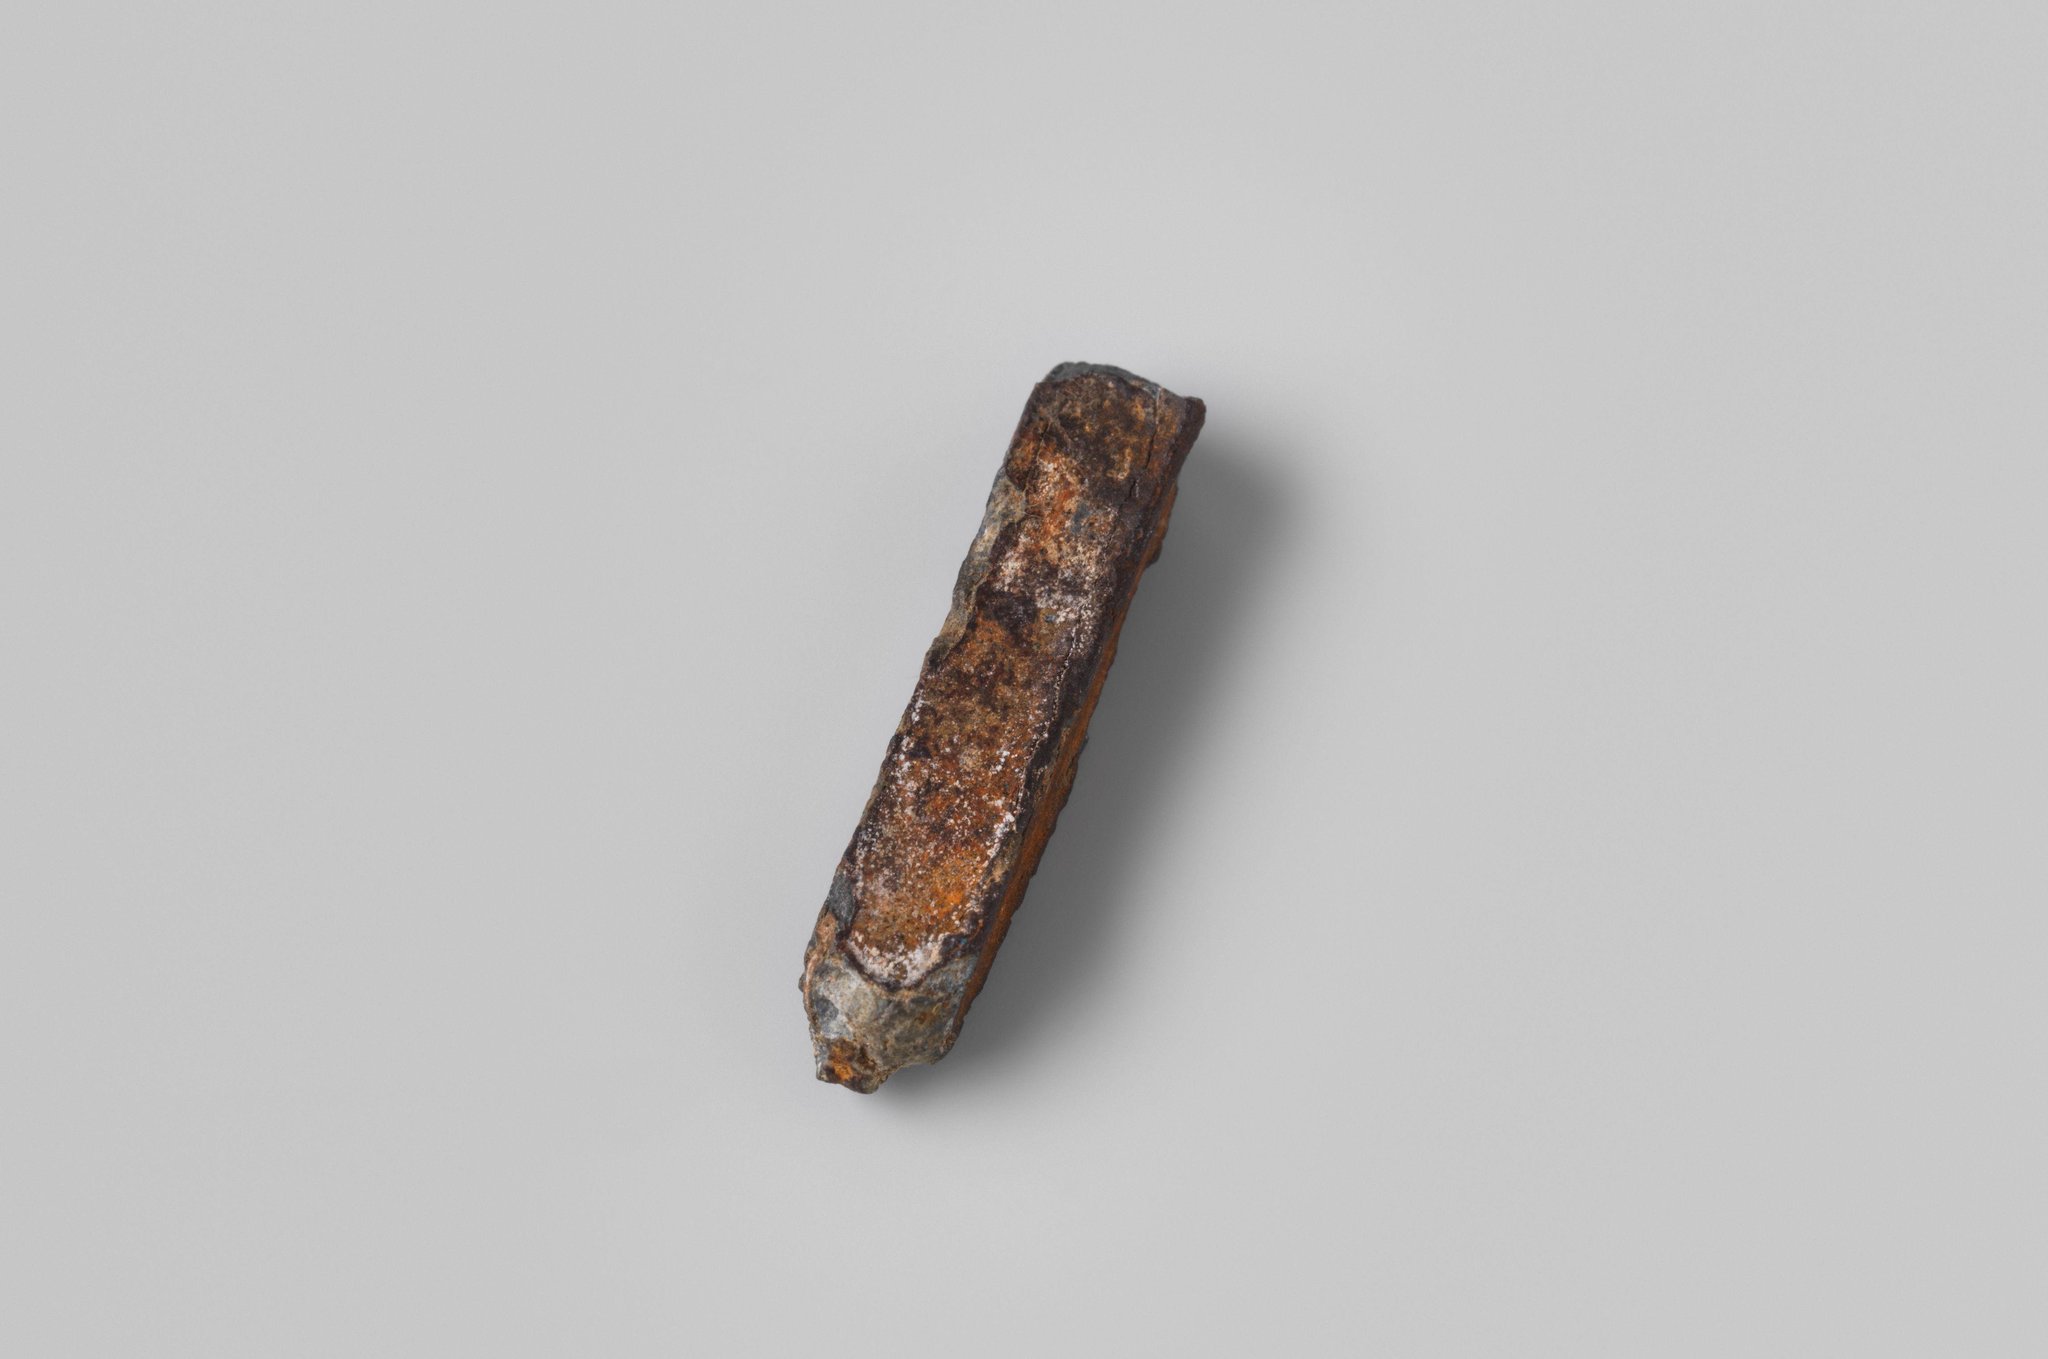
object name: type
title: Drukletter uit het wrak van de Oost-Indiëvaarder Hollandia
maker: Anonymous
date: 1700-1743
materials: lead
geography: netherlands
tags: verenigde oostindische compagnie, hollandia (schip)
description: Printing type; rectangular, eroded, groove in one side, characters illegible.